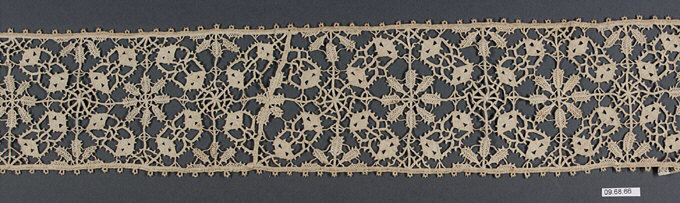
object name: border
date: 1600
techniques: lace